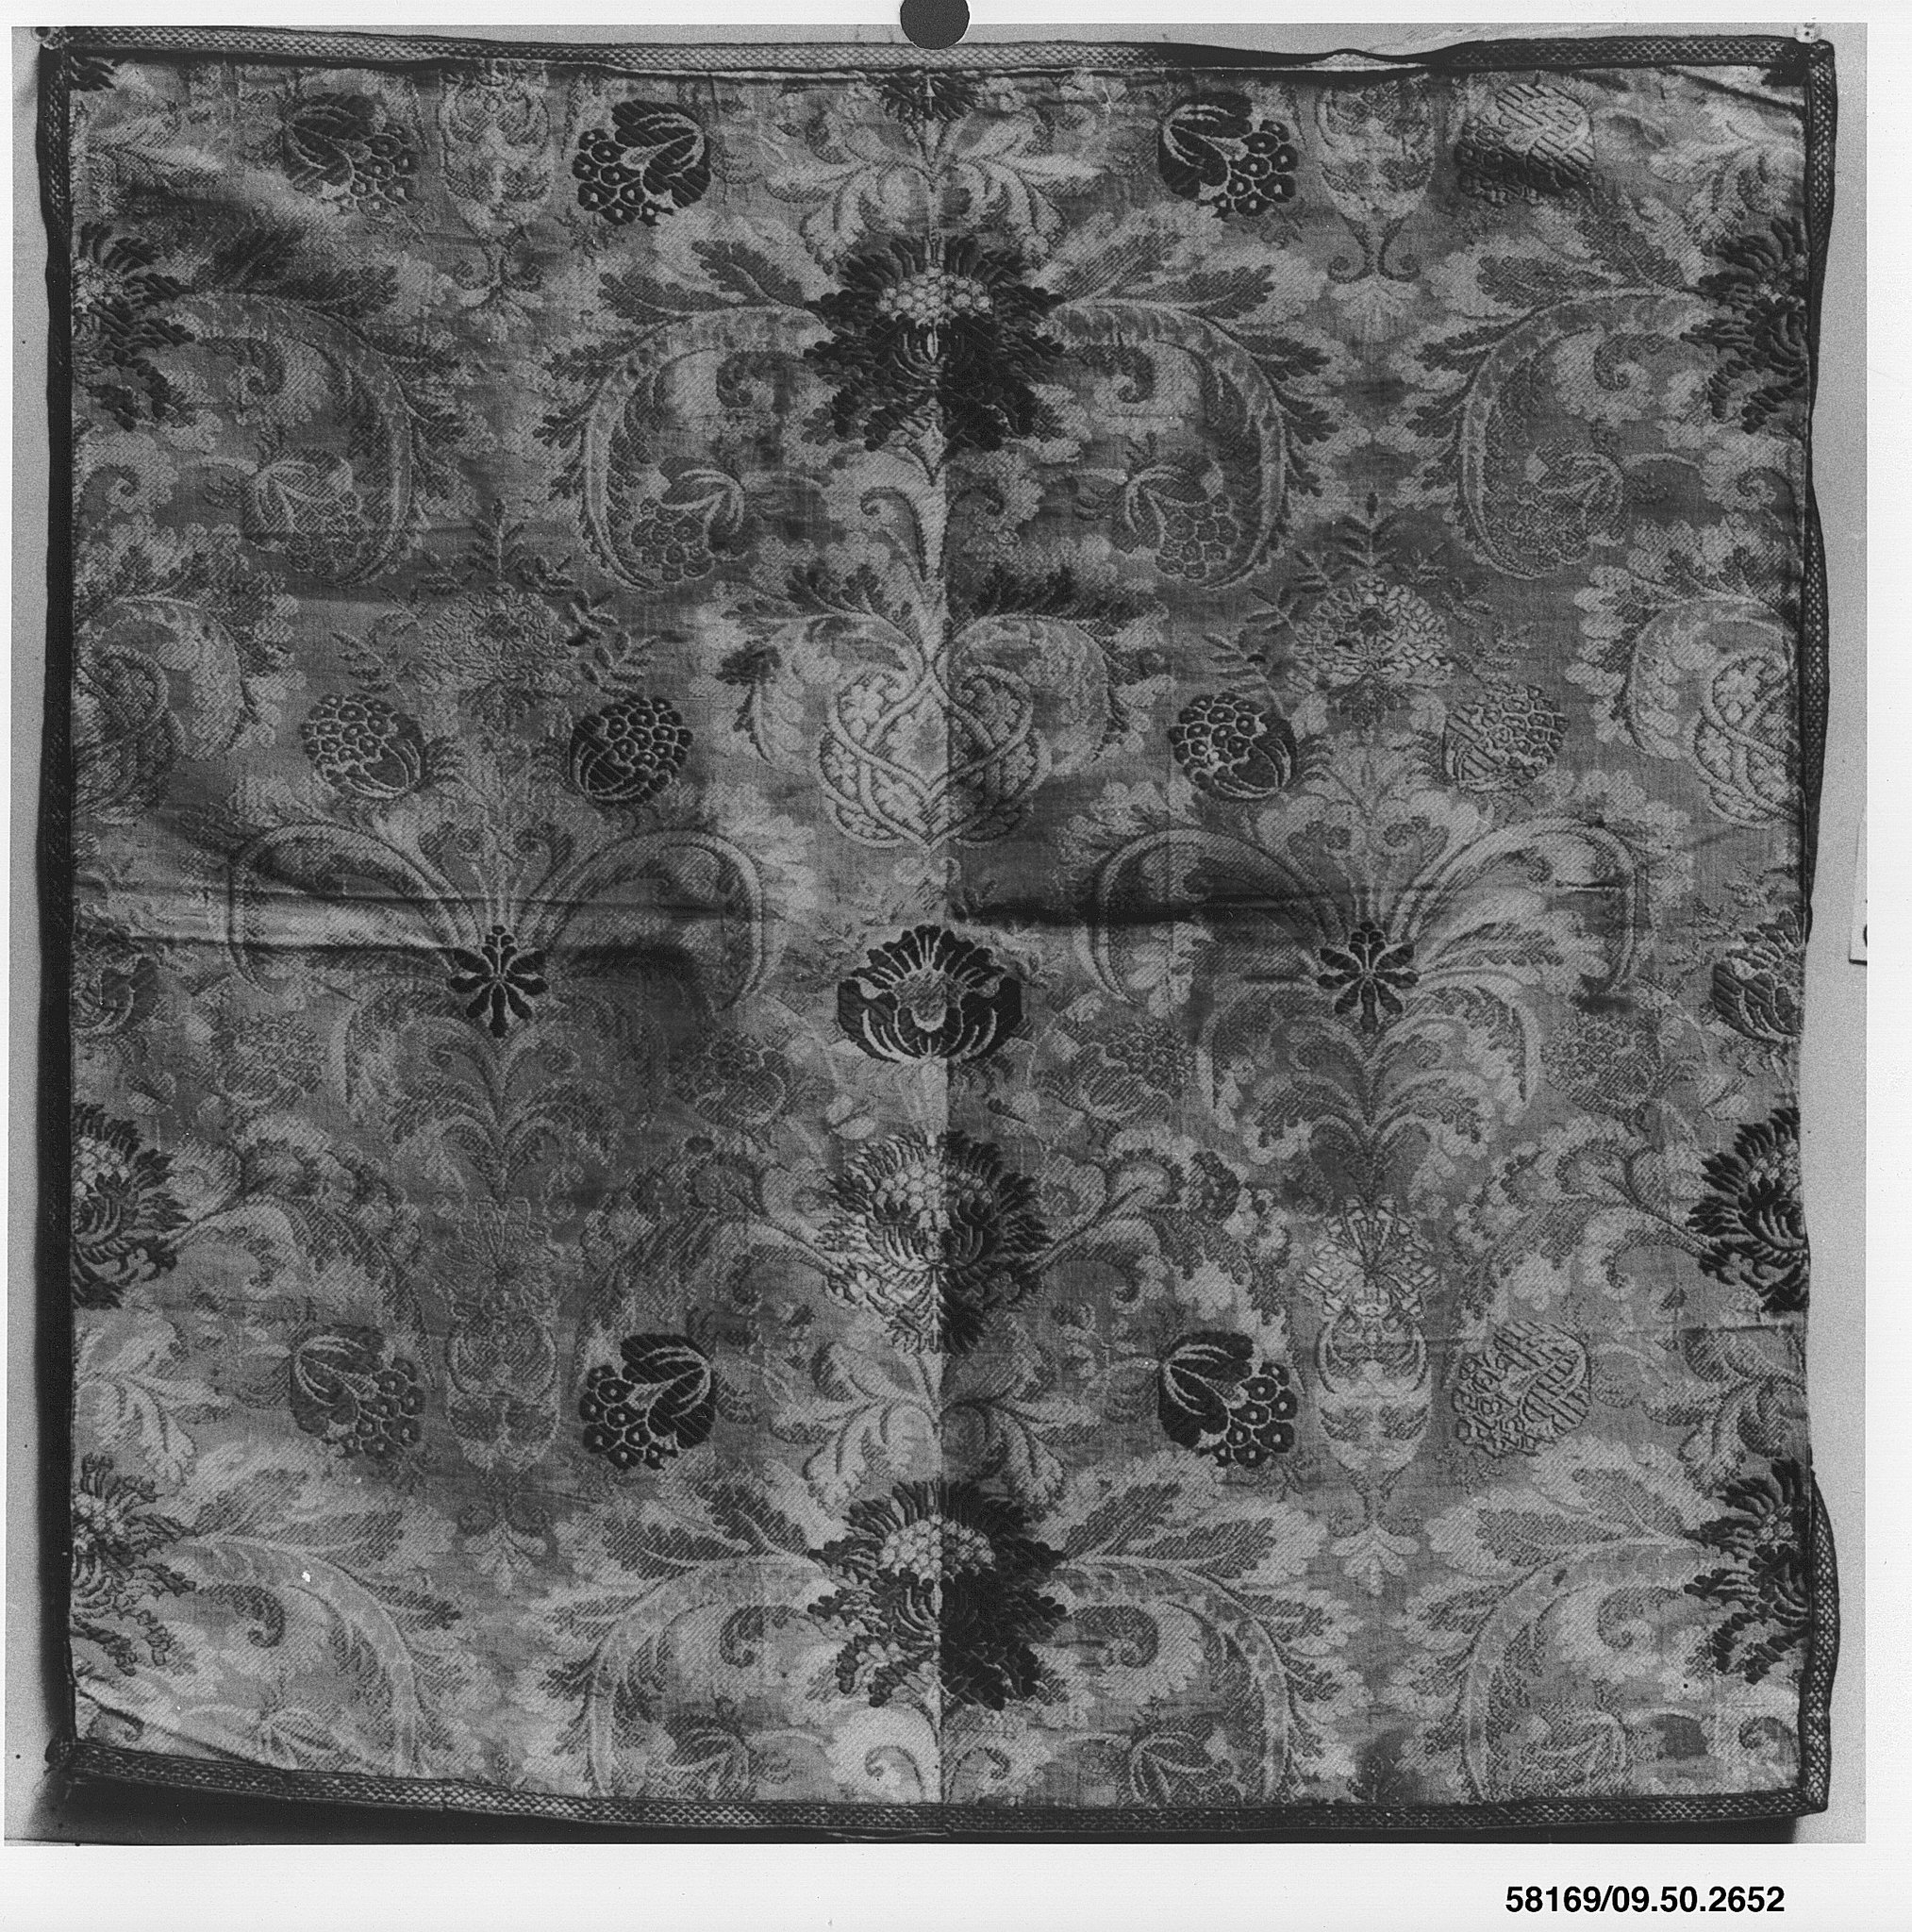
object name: piece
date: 1720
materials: silk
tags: flowers,leaves